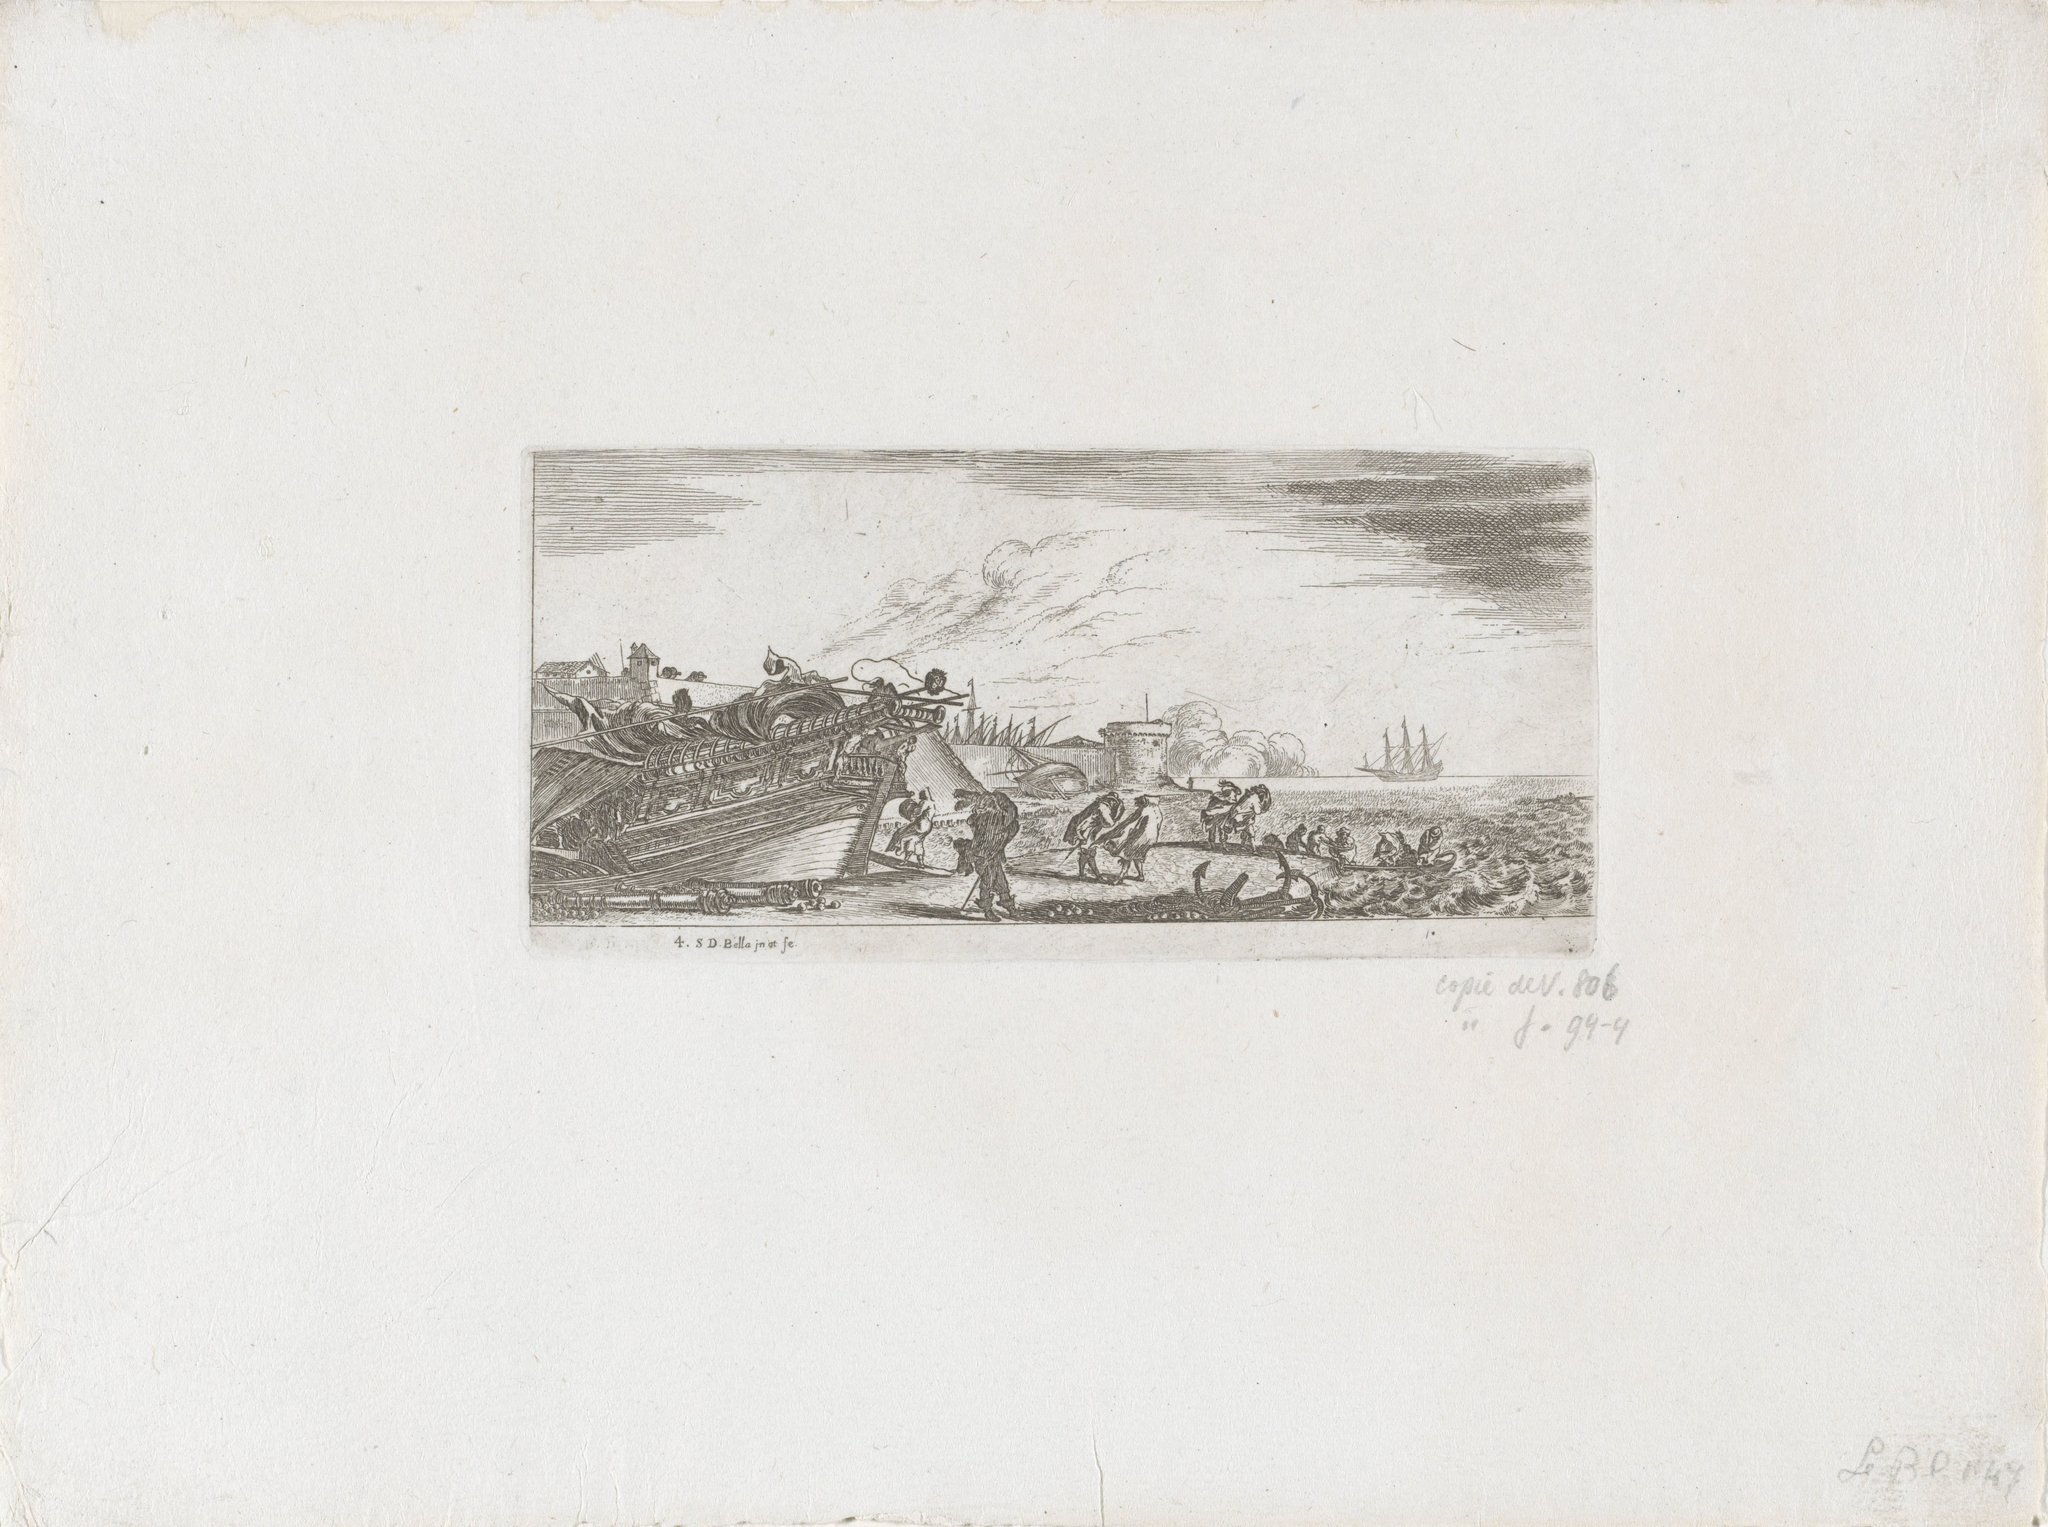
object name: print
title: Schepen en havens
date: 1620-1664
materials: paper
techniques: etching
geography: rome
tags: dock labourer, ships (in general), pier, quay, wharf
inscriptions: collector's mark: Lugt 2228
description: Prent uit een reeks van negen prenten. Zeven prenten zijn spiegelbeeldige en genummerde kopieën naar prenten van Stefano della Bella. Twee prenten zijn nieuwe inventies. Mogelijk is deze gekopieerde reeks ook door Della Bella zelf vervaardigd.